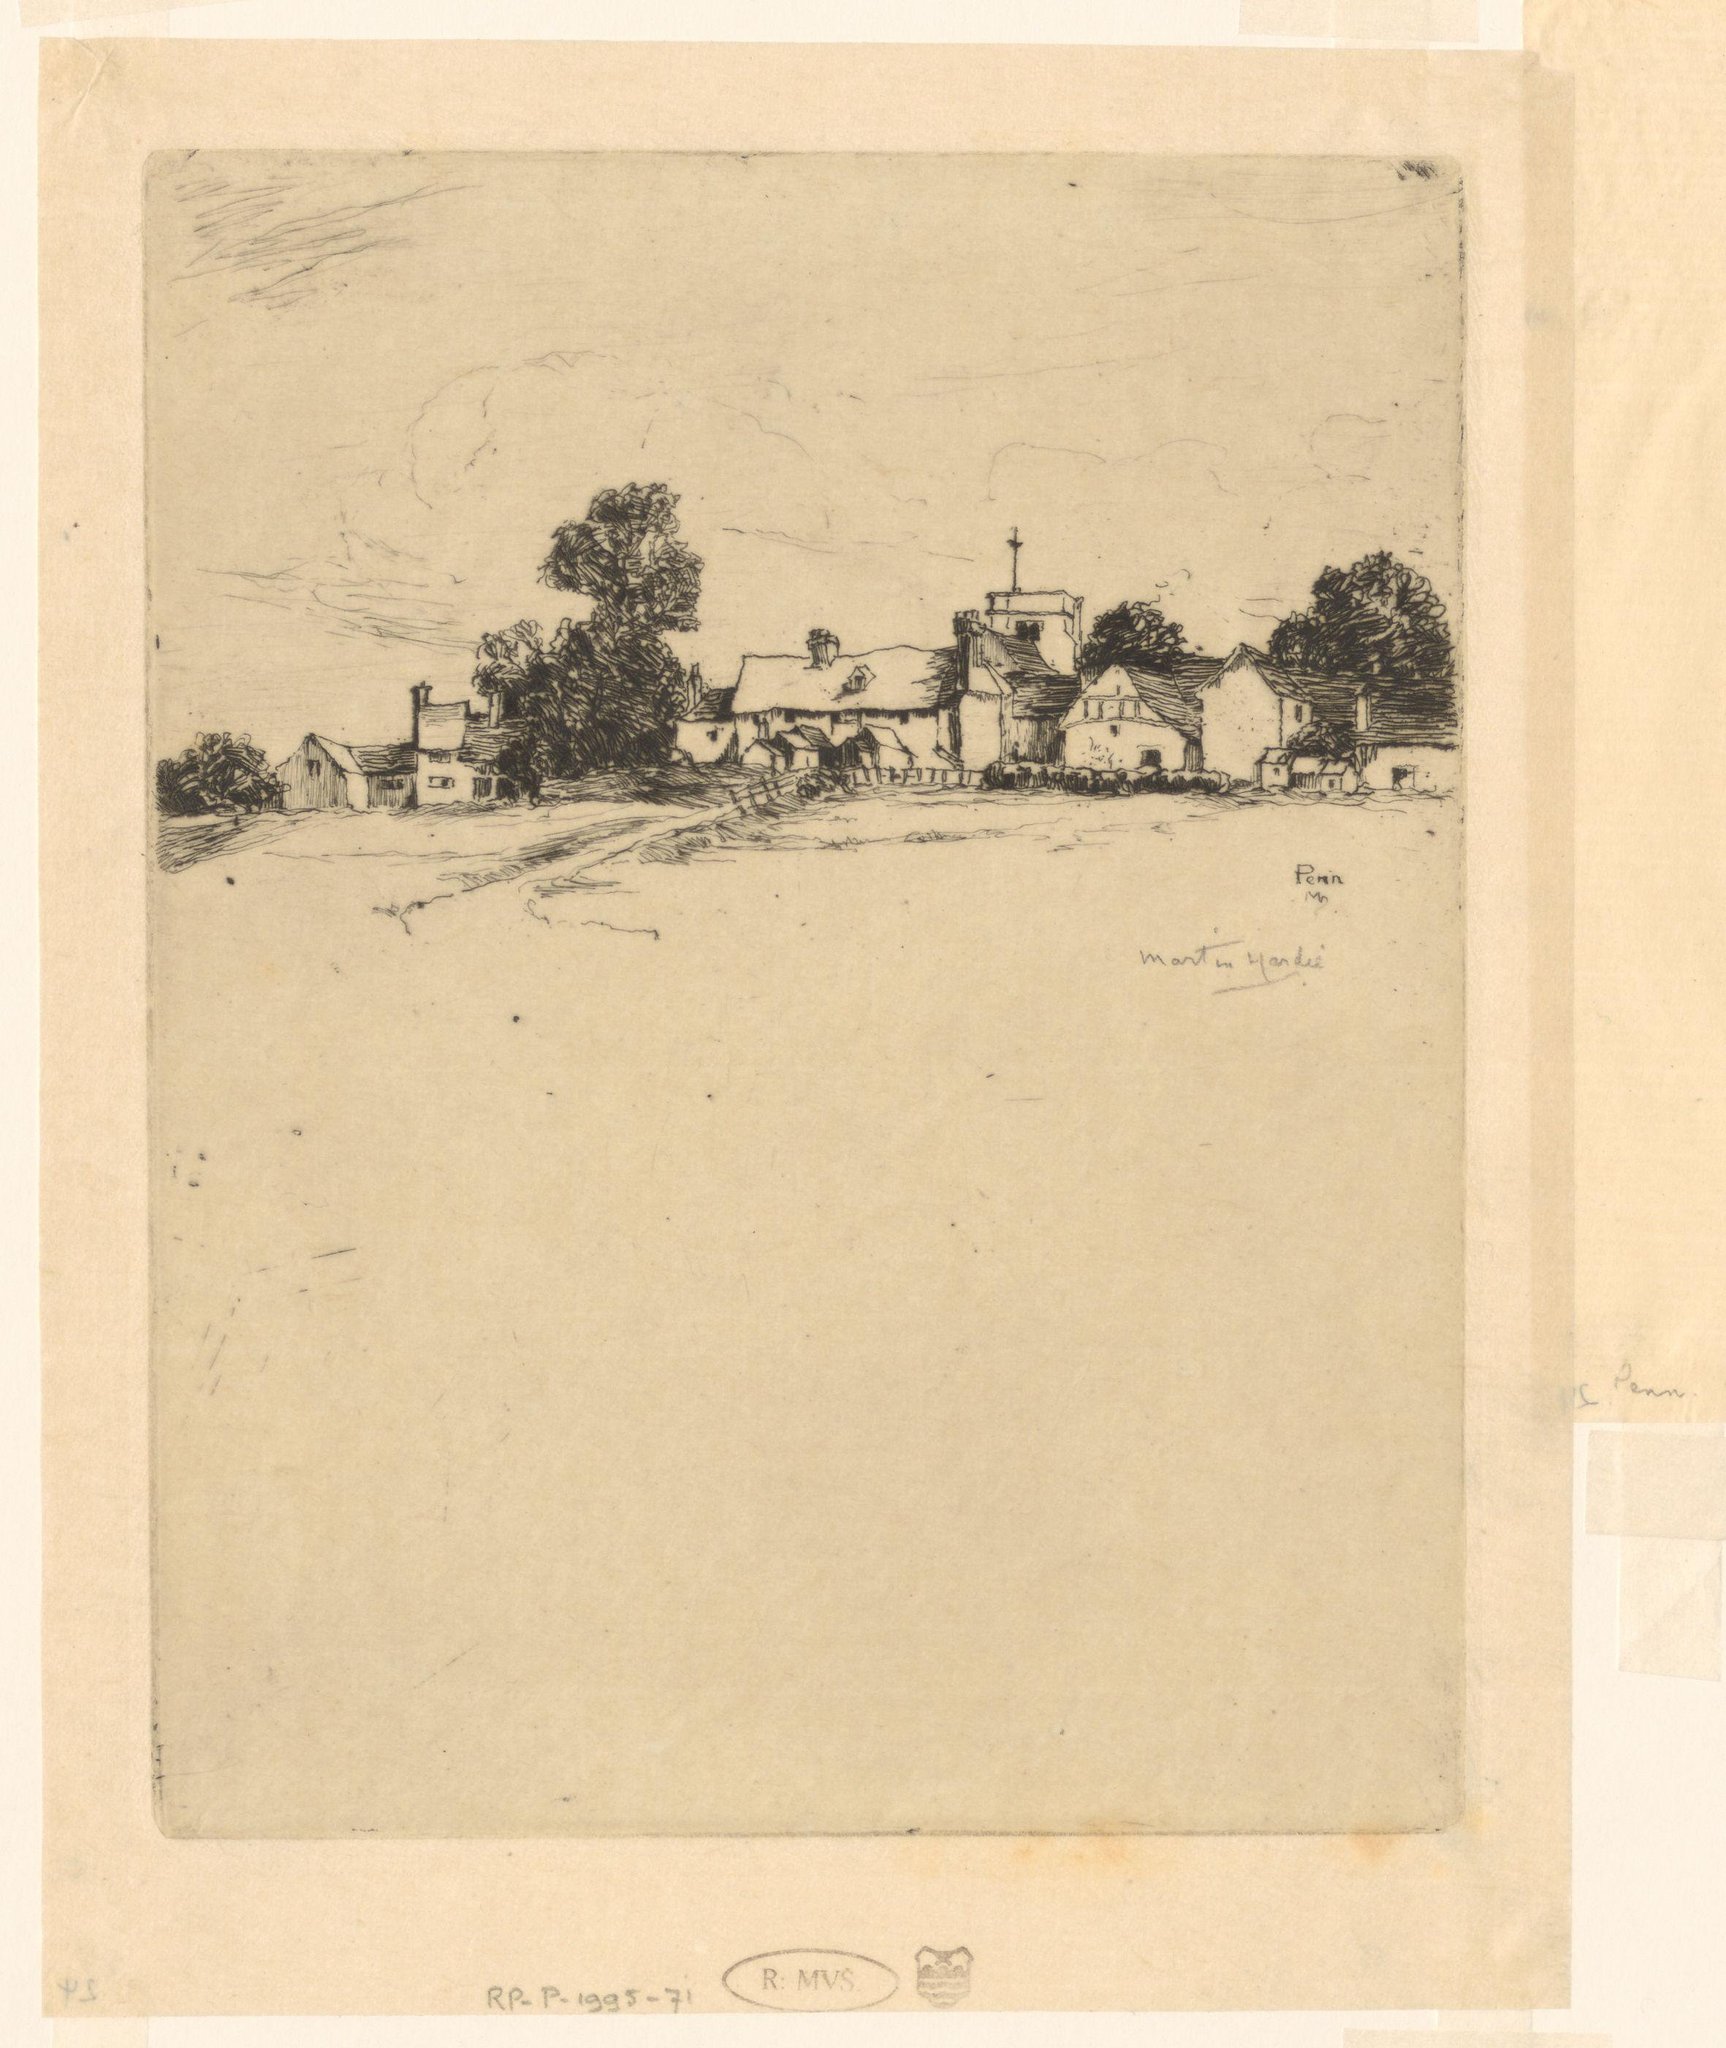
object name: print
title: Penn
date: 1909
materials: paper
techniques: etching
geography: penn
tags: prospect of village, silhouette of village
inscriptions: collector's mark: Lugt 2760, collector's mark: Lugt 2228, annotation: ‘Martin Hardie’